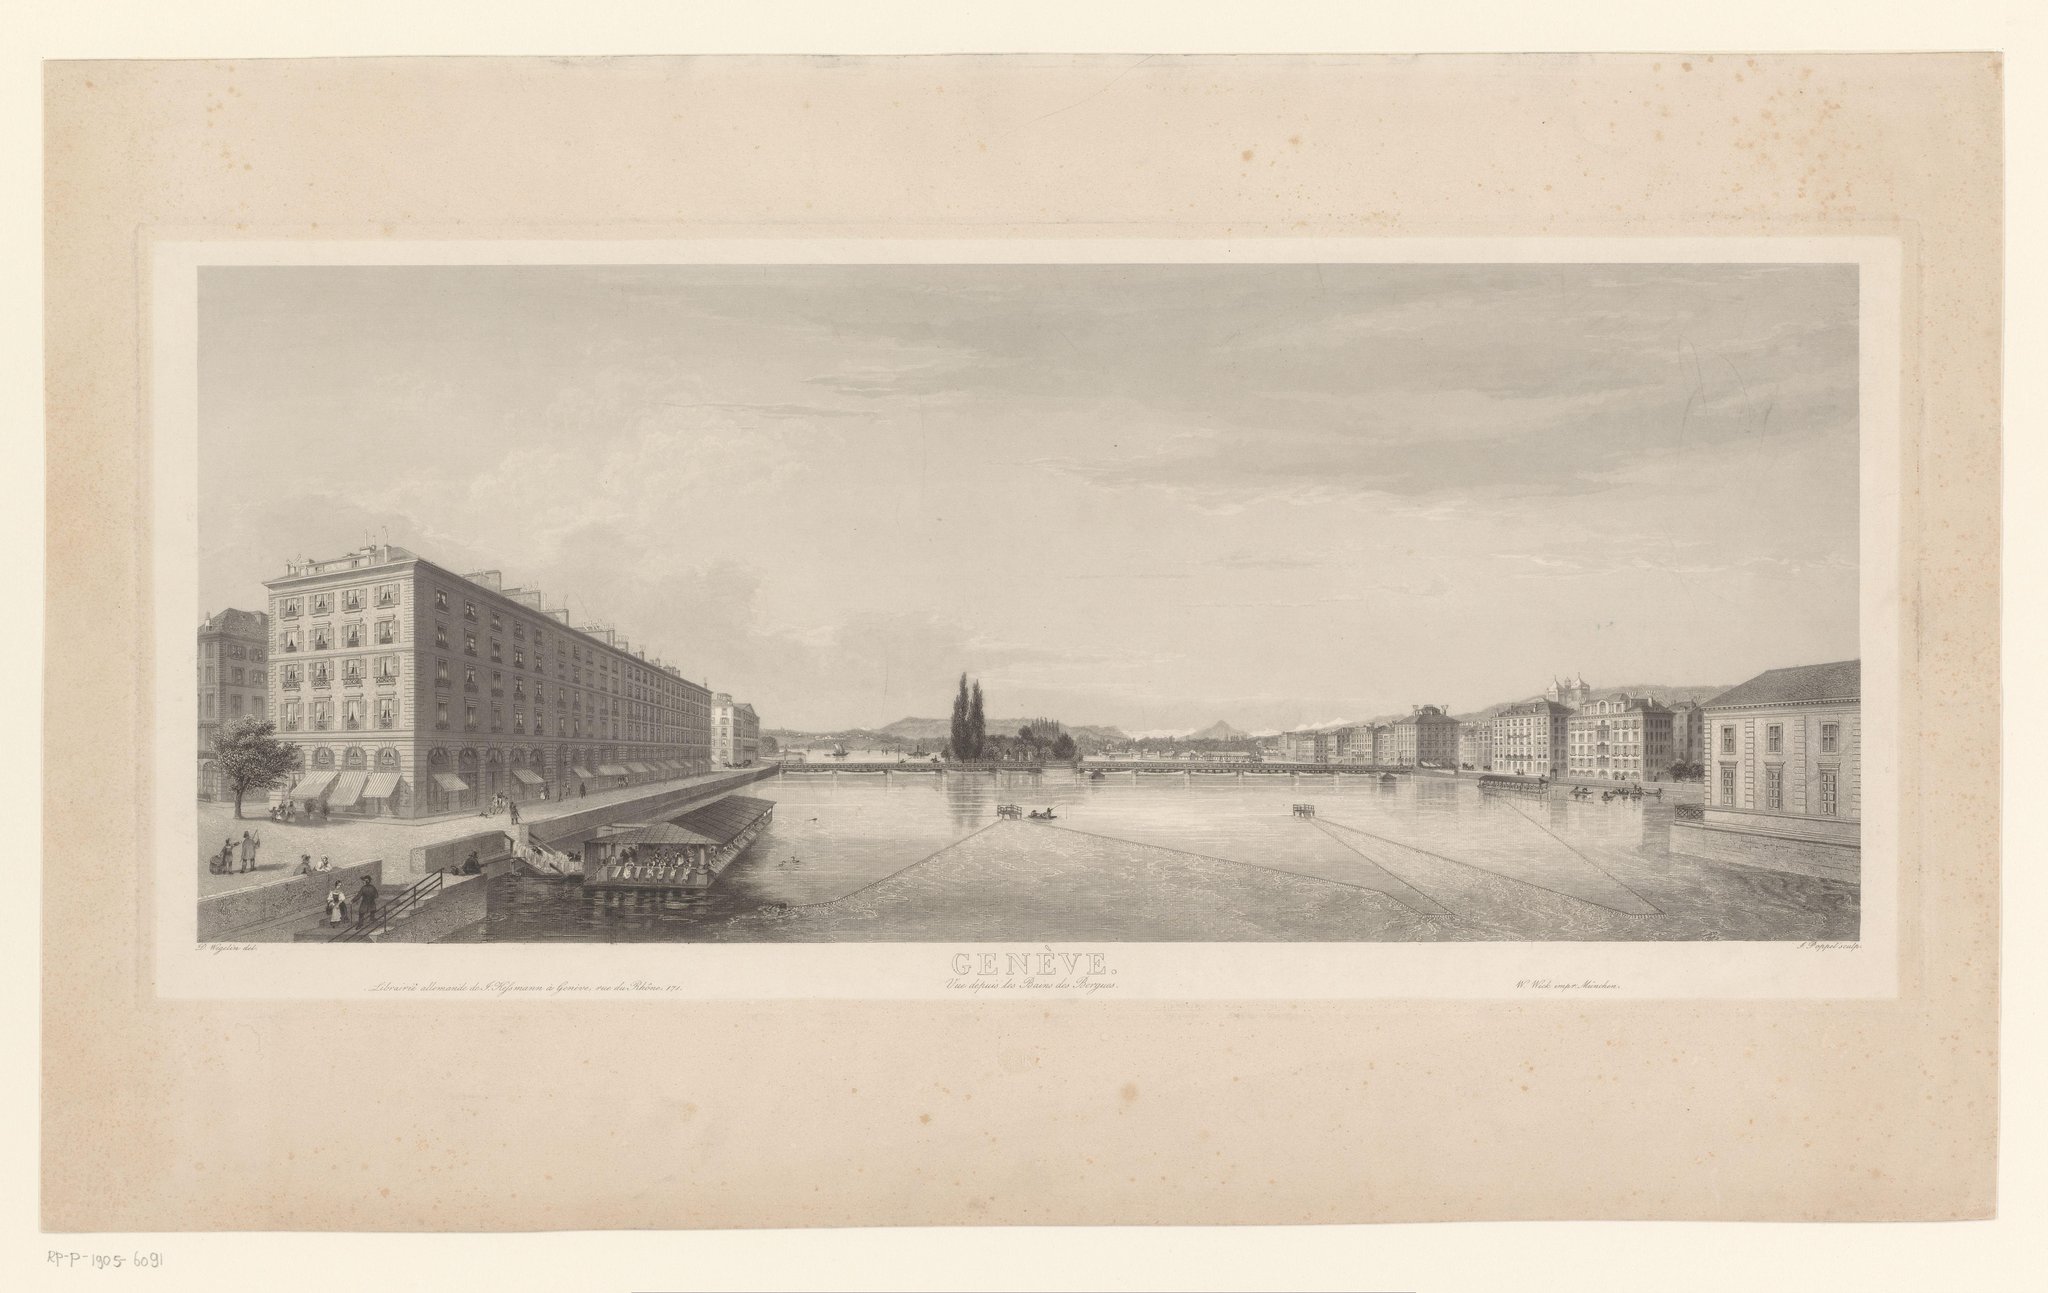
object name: print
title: Gezicht op Genève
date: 1817-1882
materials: paper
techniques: engraving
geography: geneva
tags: lake, city-view in general; 'veduta' (+ city(-scape) with figures, staffage)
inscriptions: collector's mark: ‘JR’, collector's mark: Lugt 2228